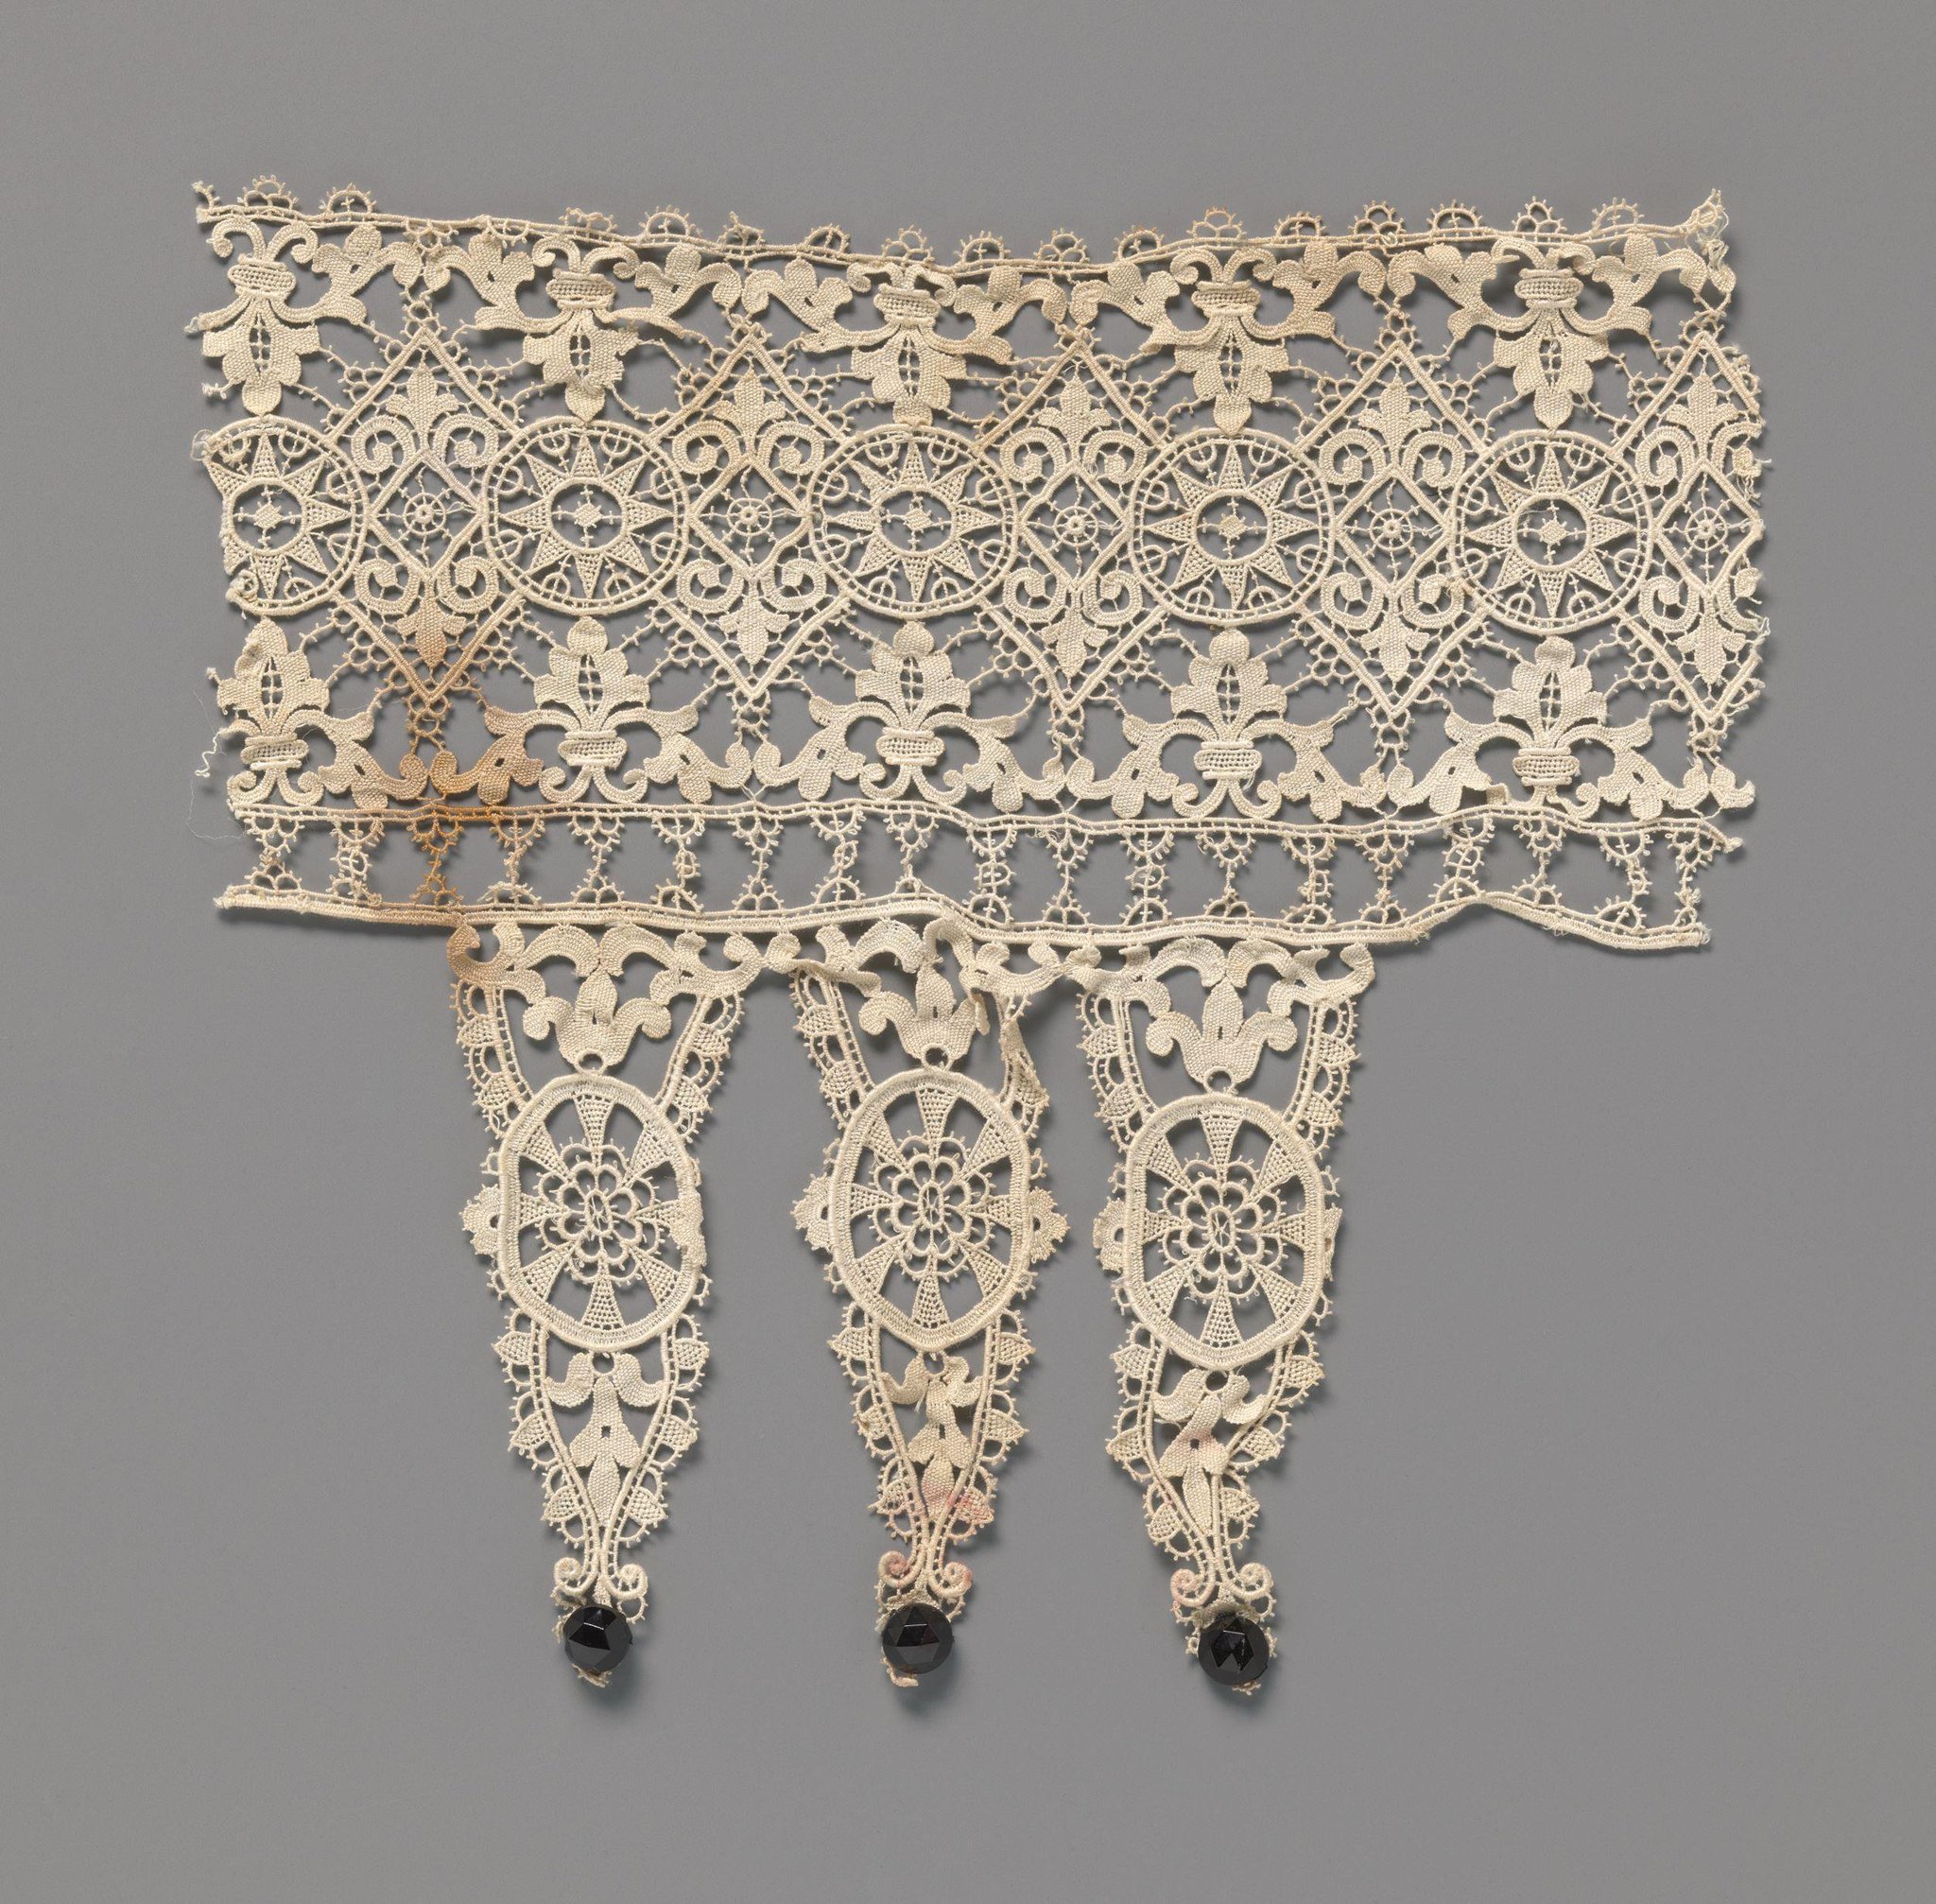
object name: decoration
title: Meubelversiering van machinale kant met gitten aan lange puntschulpen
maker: Anonymous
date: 1900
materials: cotton, jet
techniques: lace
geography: switzerland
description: Meubelversiering van naturelkleurige machinale kant: etskant. Het kant imiteert naaldkant: reticella en punto in aria. Aan een rechthoekige strook hangen drie puntschulpen met in het midden een rozet in een staand ovaal medaillon en aan de punt een zwart knopje van git of een imitatie van git.